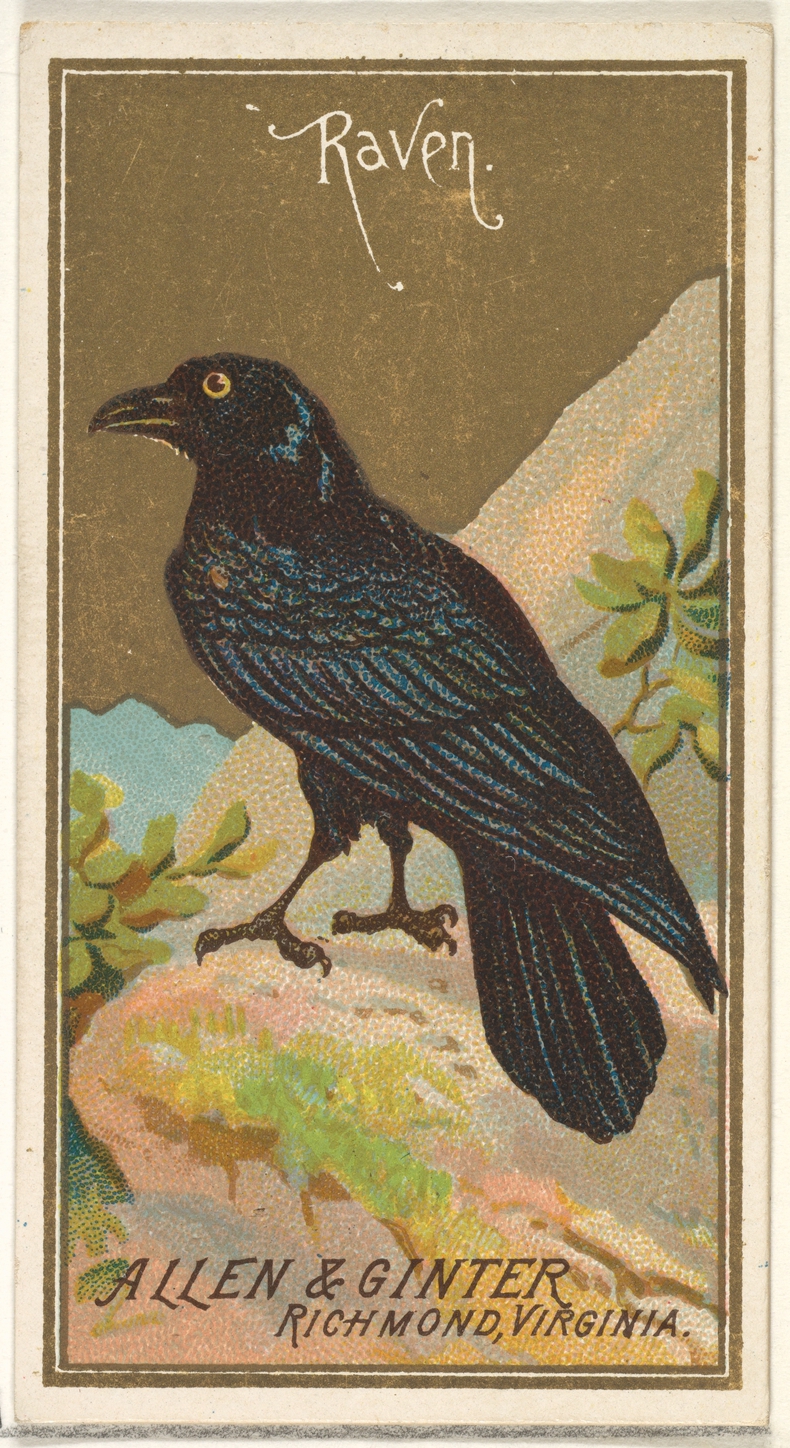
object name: print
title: Raven, from the Birds of America series (N4) for Allen & Ginter Cigarettes Brands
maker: allen & ginter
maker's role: publisher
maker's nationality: american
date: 1888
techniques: color lithograph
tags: birds